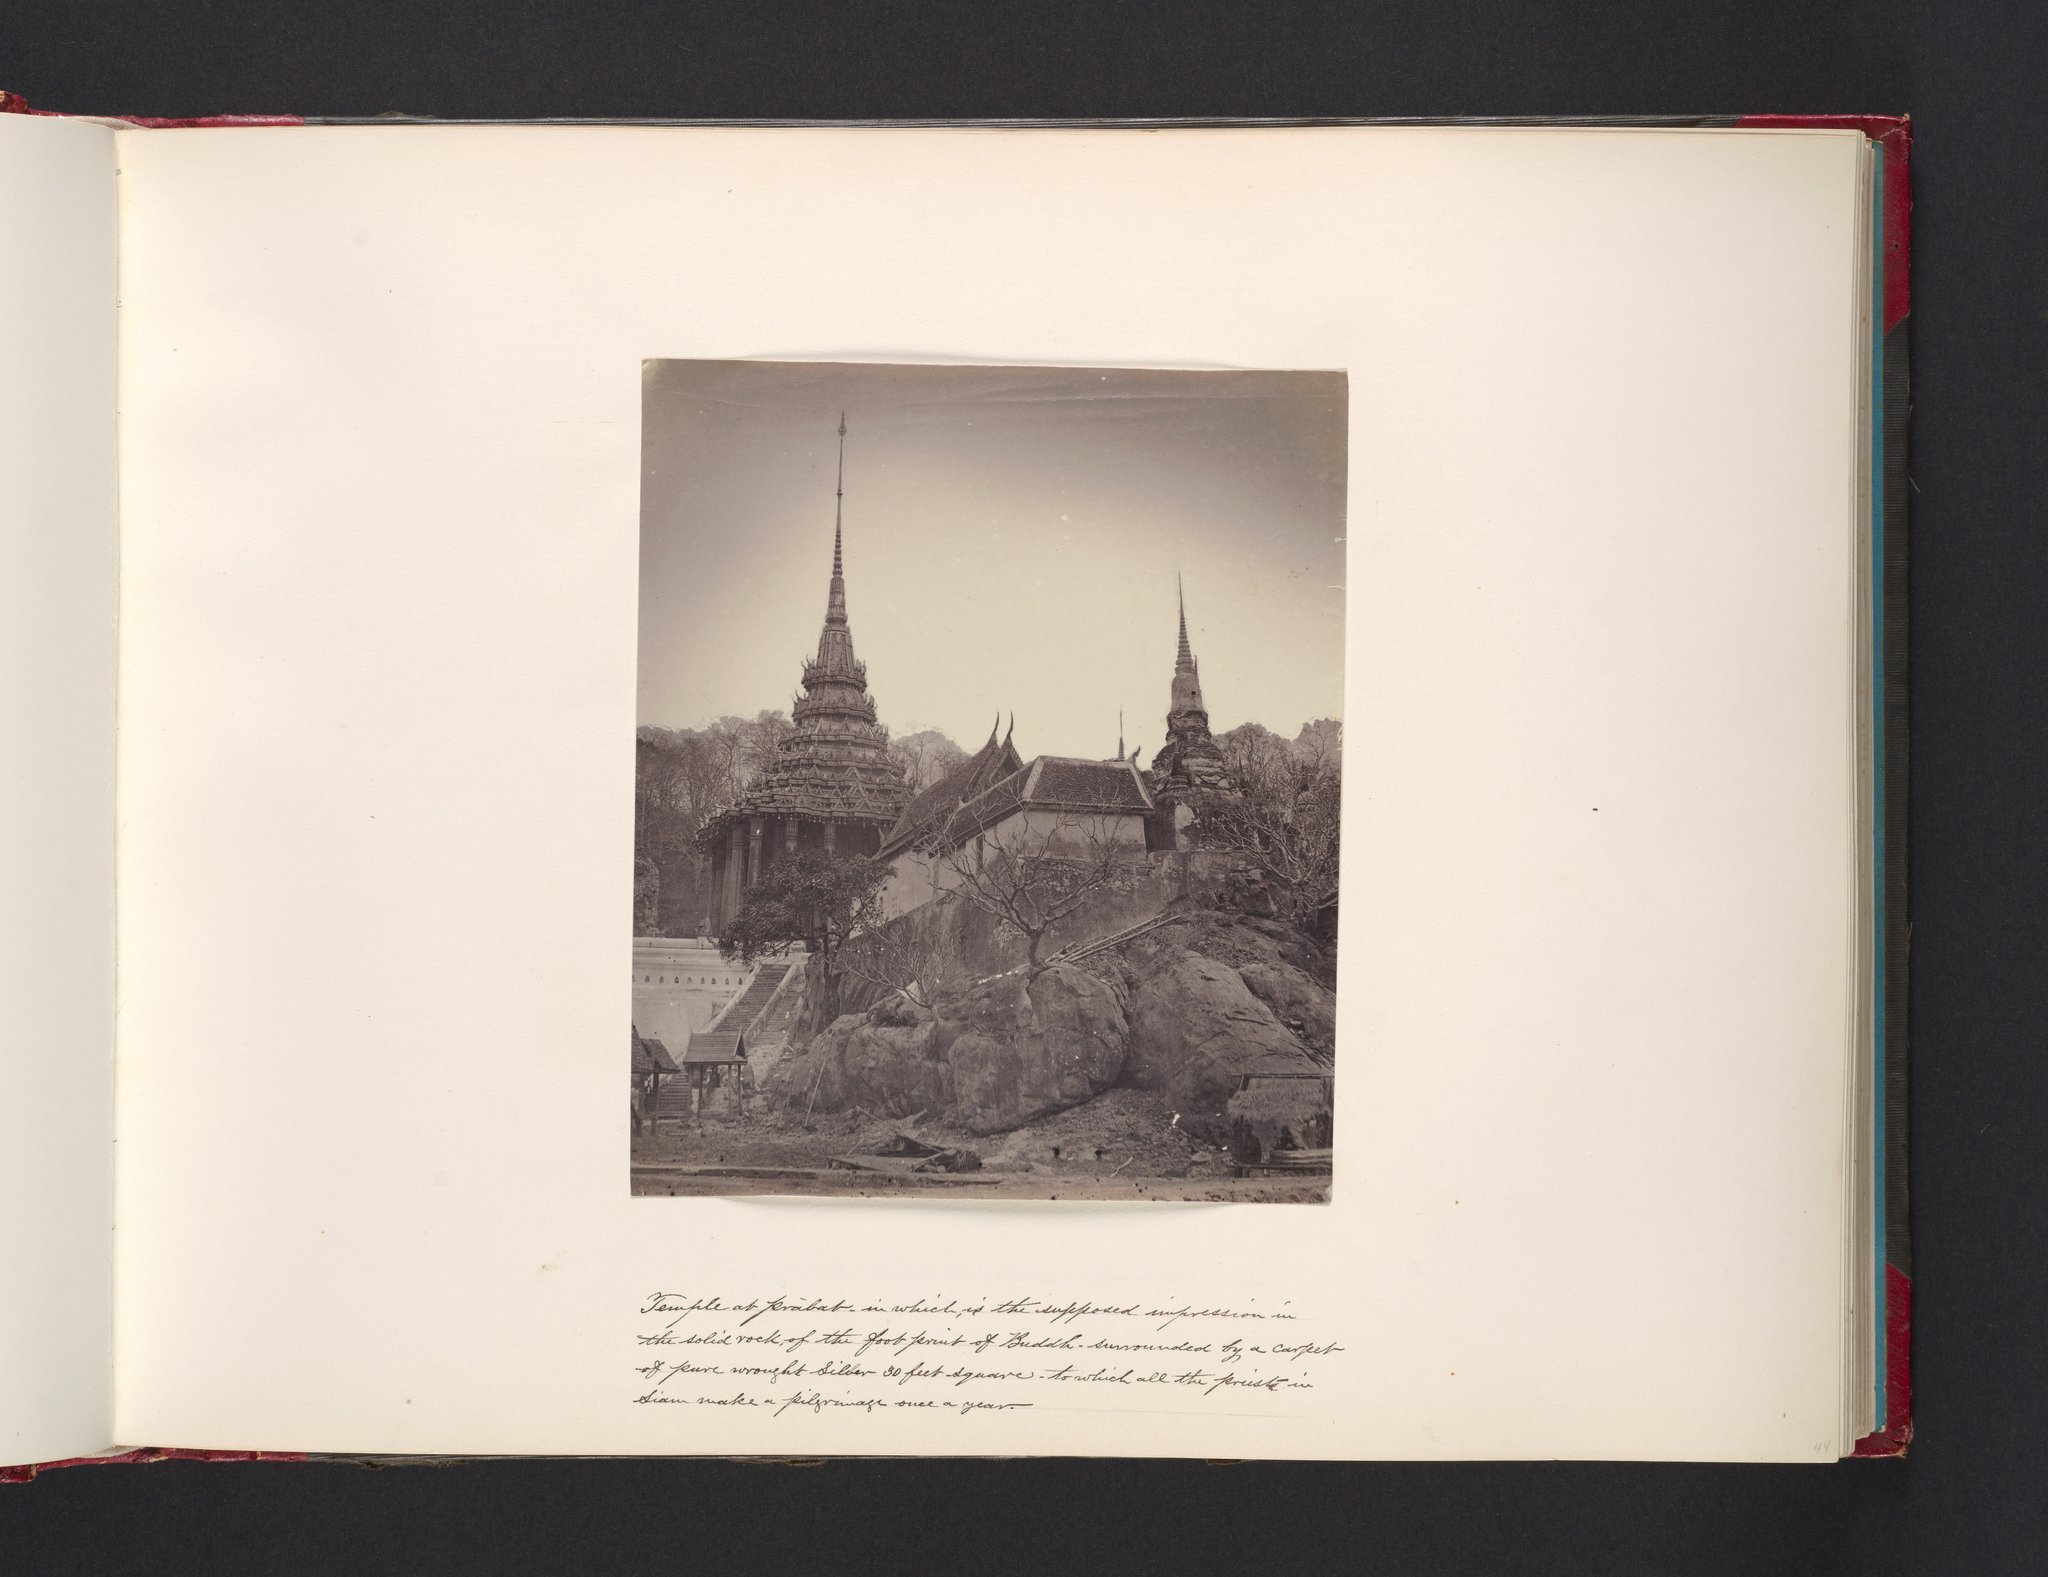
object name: photograph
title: Temple at Prabat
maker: john thomson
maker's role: artist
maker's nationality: british, scottish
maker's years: 1837-1921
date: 1865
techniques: albumen silver print, glass negative